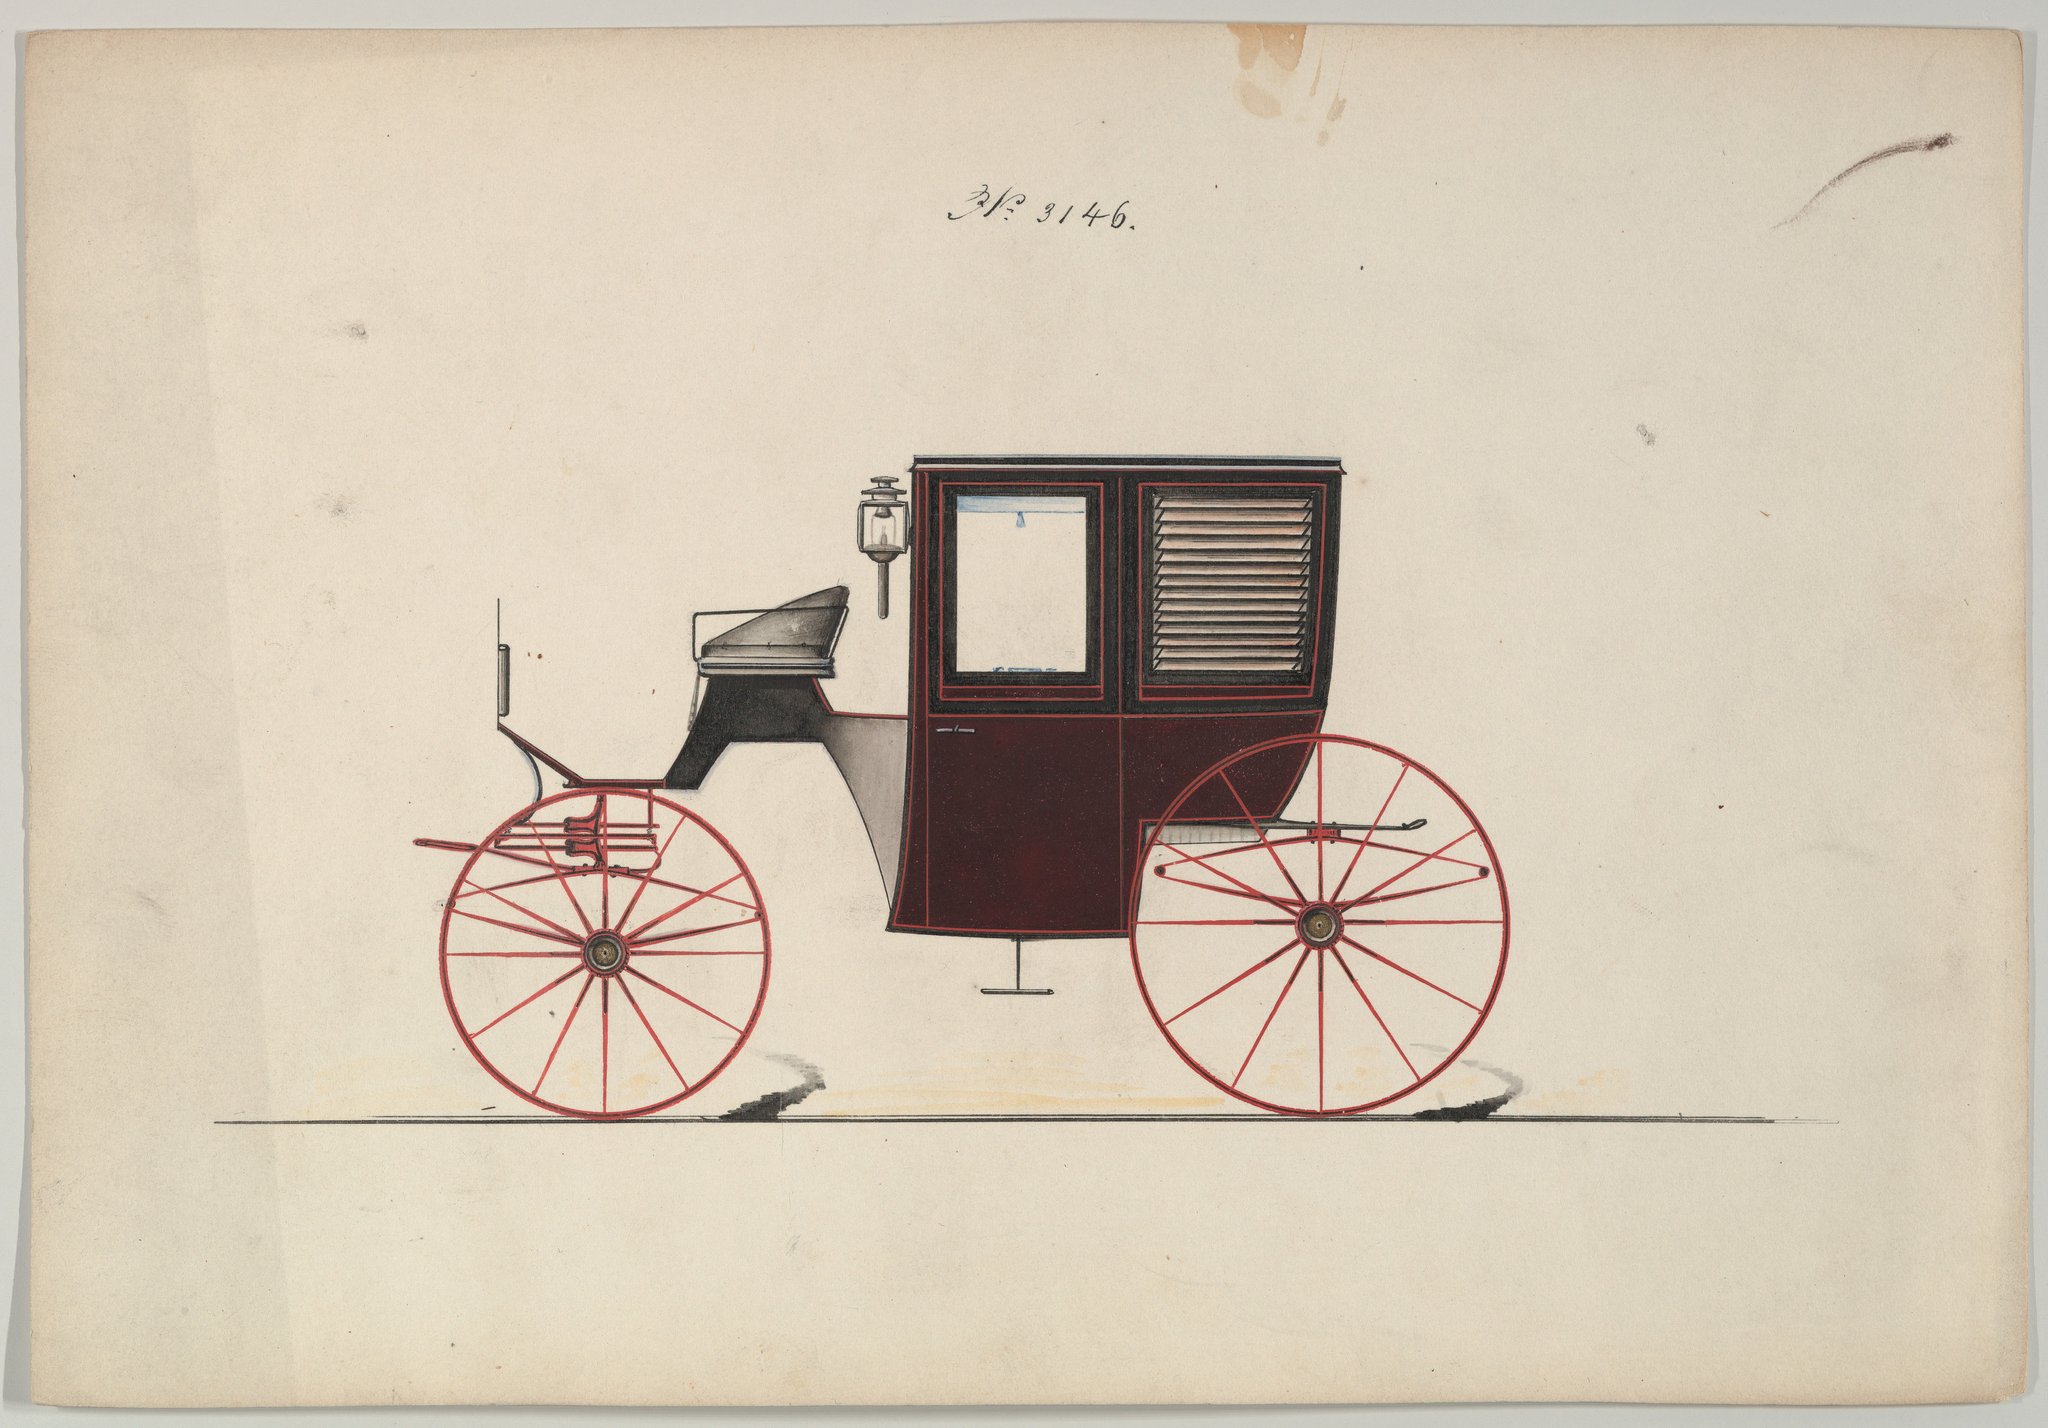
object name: drawing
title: Brougham #3146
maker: brewster & co.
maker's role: manufacturer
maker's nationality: american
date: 1875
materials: gouache, gum arabic, ink, watercolor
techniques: pen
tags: carriages